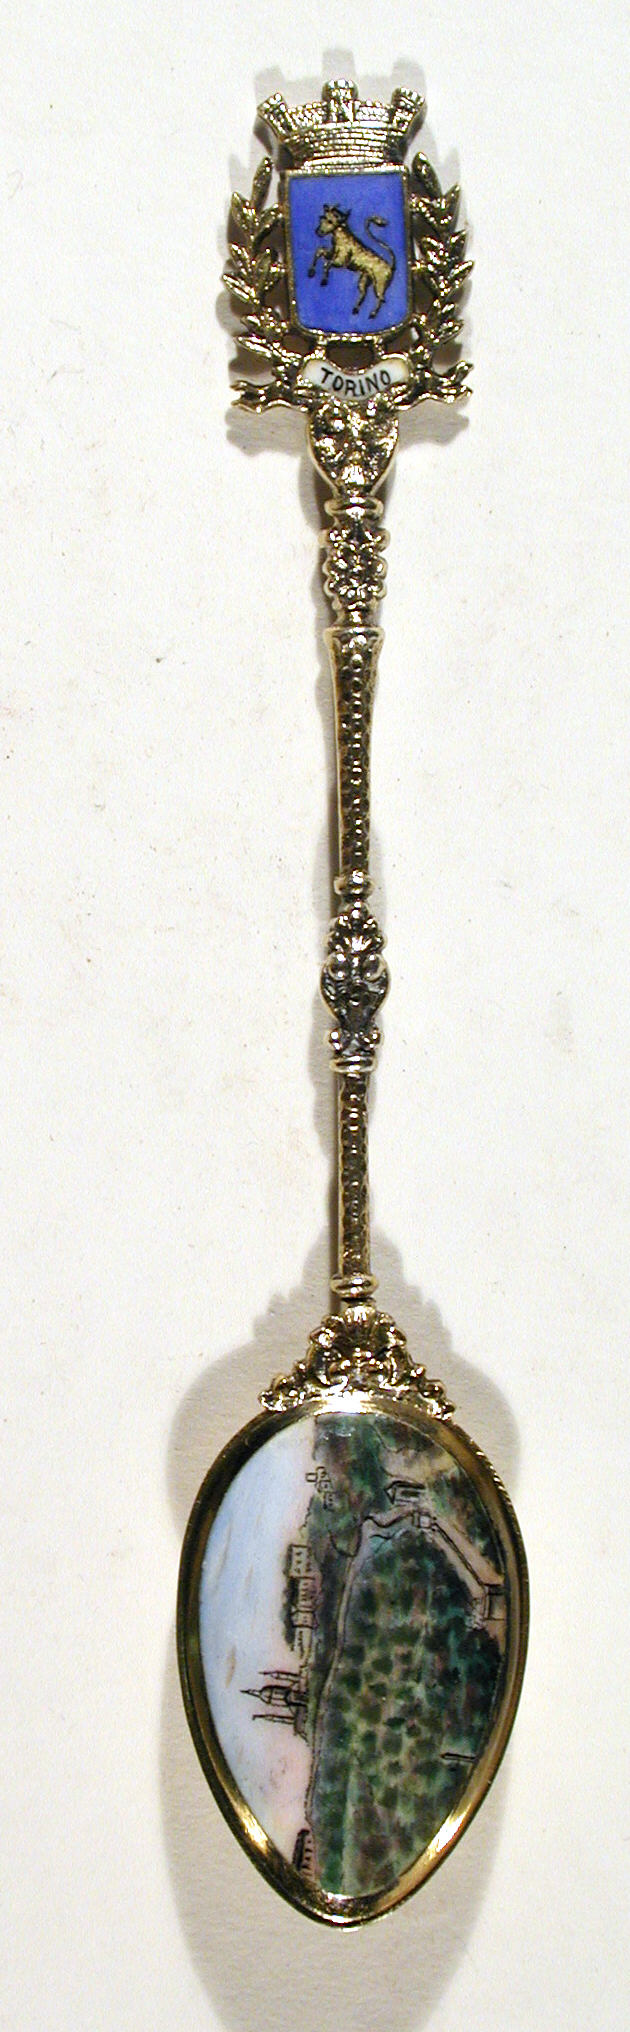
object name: souvenir spoon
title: Souvenir spoon with view of Turin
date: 1867-1900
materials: enamel, gilt, silver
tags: buildings,roads,coat of arms